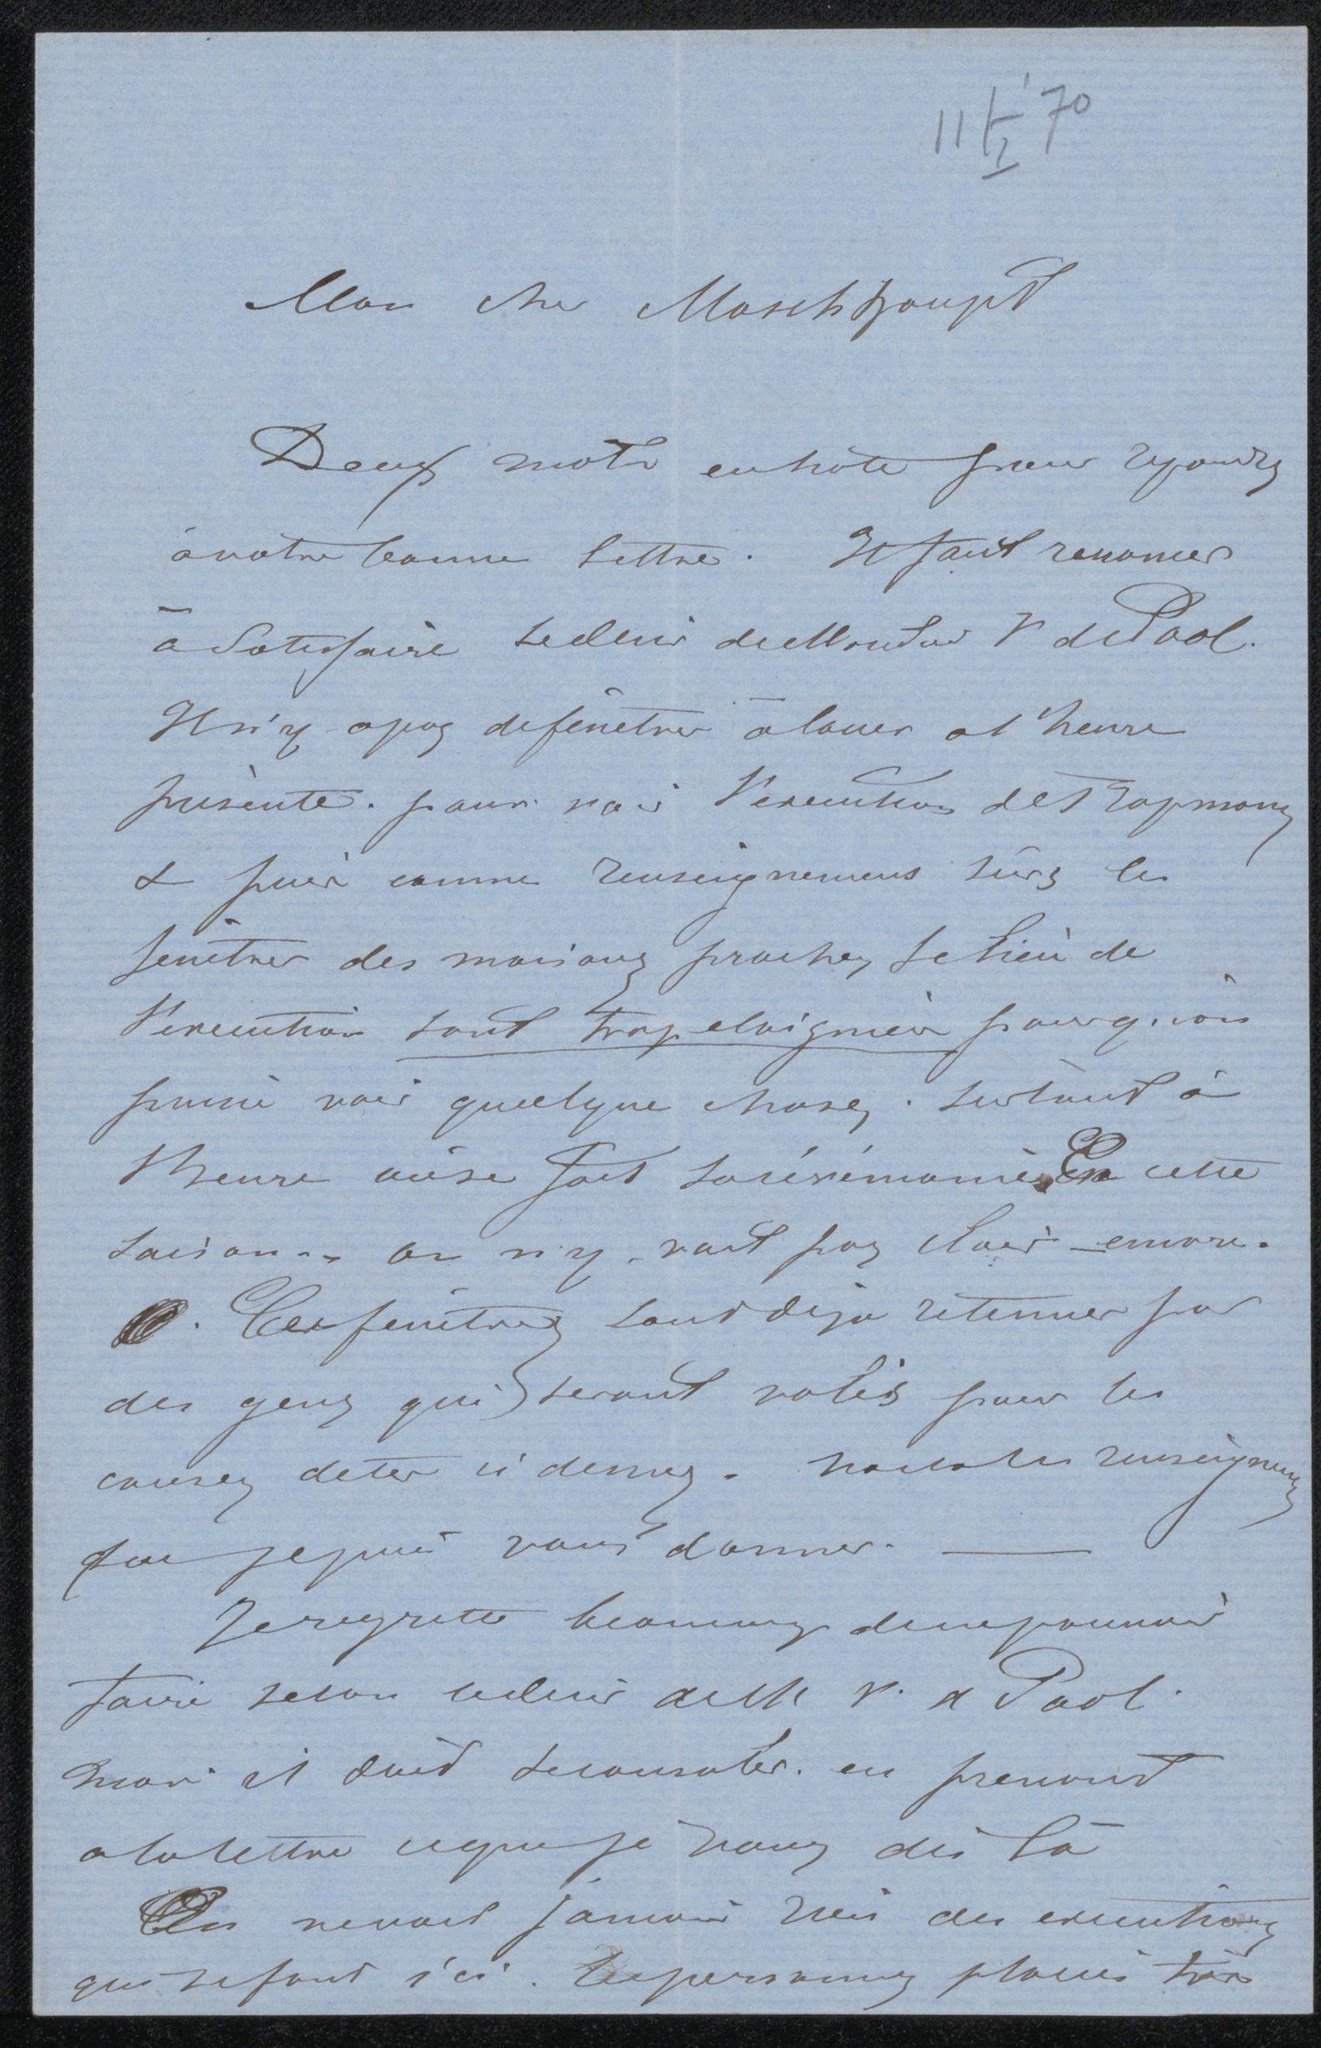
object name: letter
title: Brief aan Jan Hendrik Maschaupt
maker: adolphe mouilleron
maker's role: draughtsman, print maker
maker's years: 1820-1881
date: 1870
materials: ink, paper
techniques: pen, writing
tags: painter, jan hendrik maschaupt, leiden, rembrandt van rijn, painting (including book-illumination, miniature-painting), money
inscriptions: collector's mark: ‘RPK’